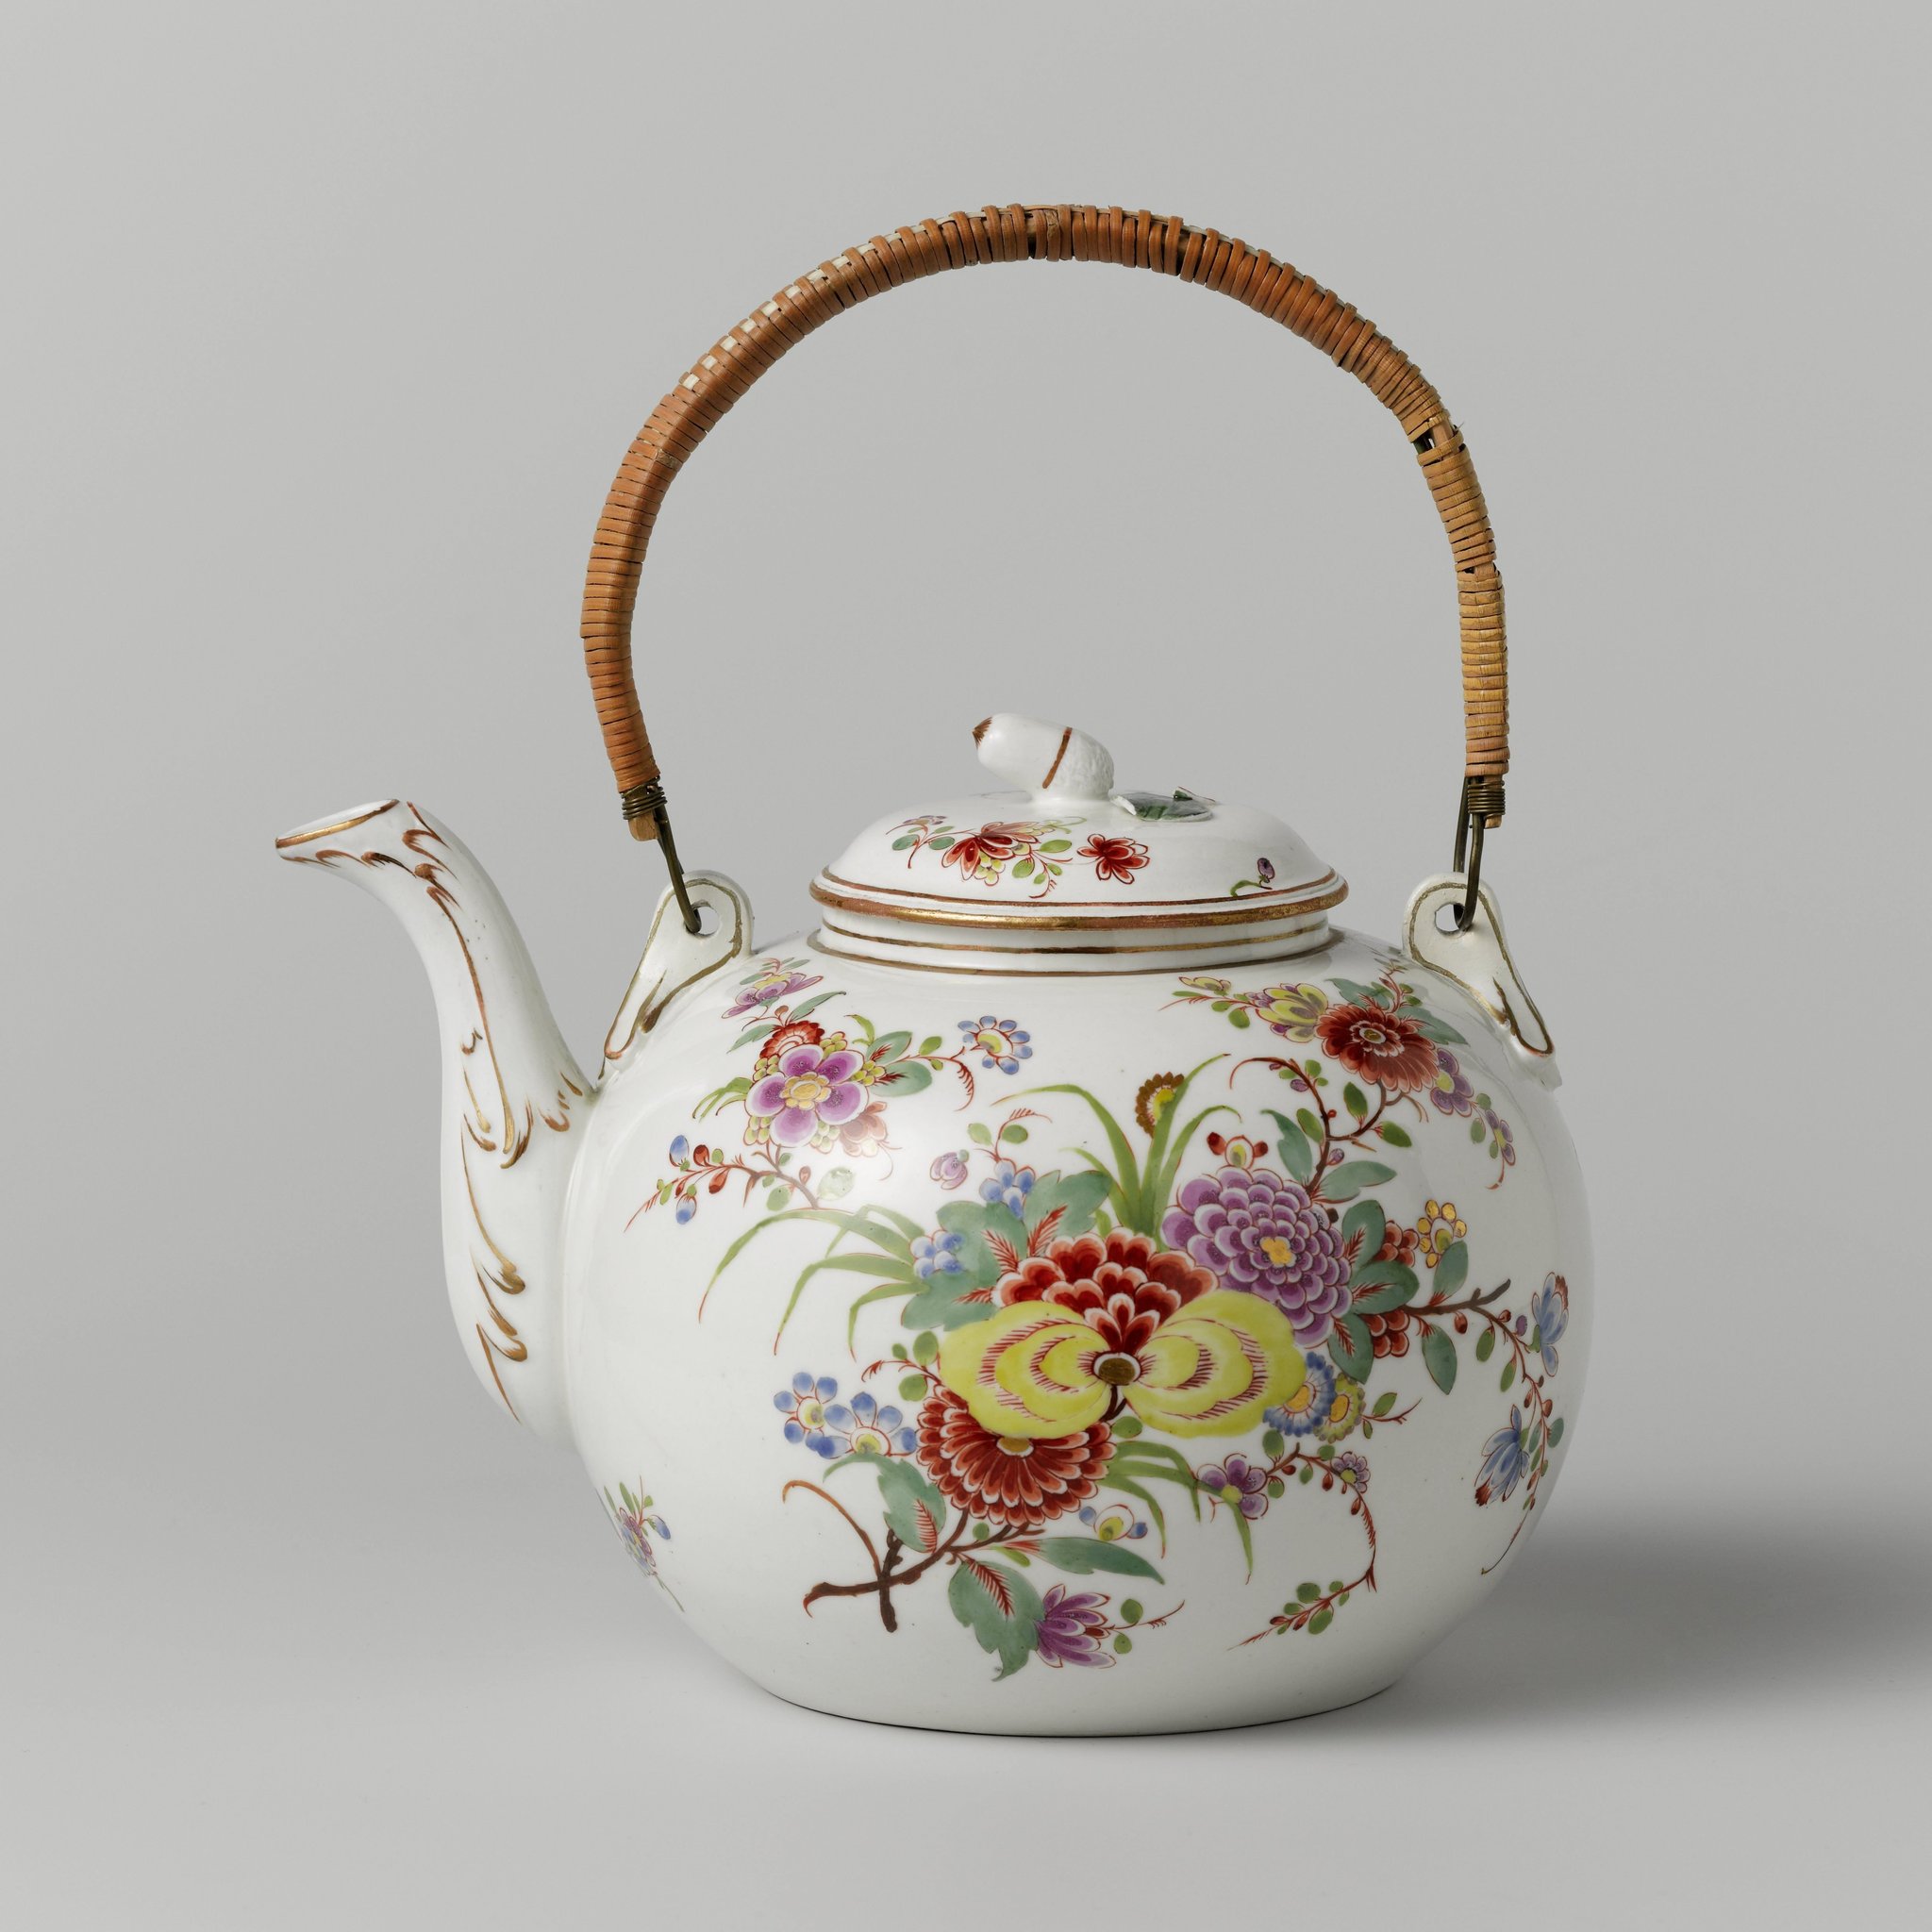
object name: kettle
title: Water kettle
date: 1778-1782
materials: porcelain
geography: loosdrecht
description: Manufactuur Oud-Loosdrecht Loosdrecht, c. 1778–1782 hard-paste porcelain, copper, cane